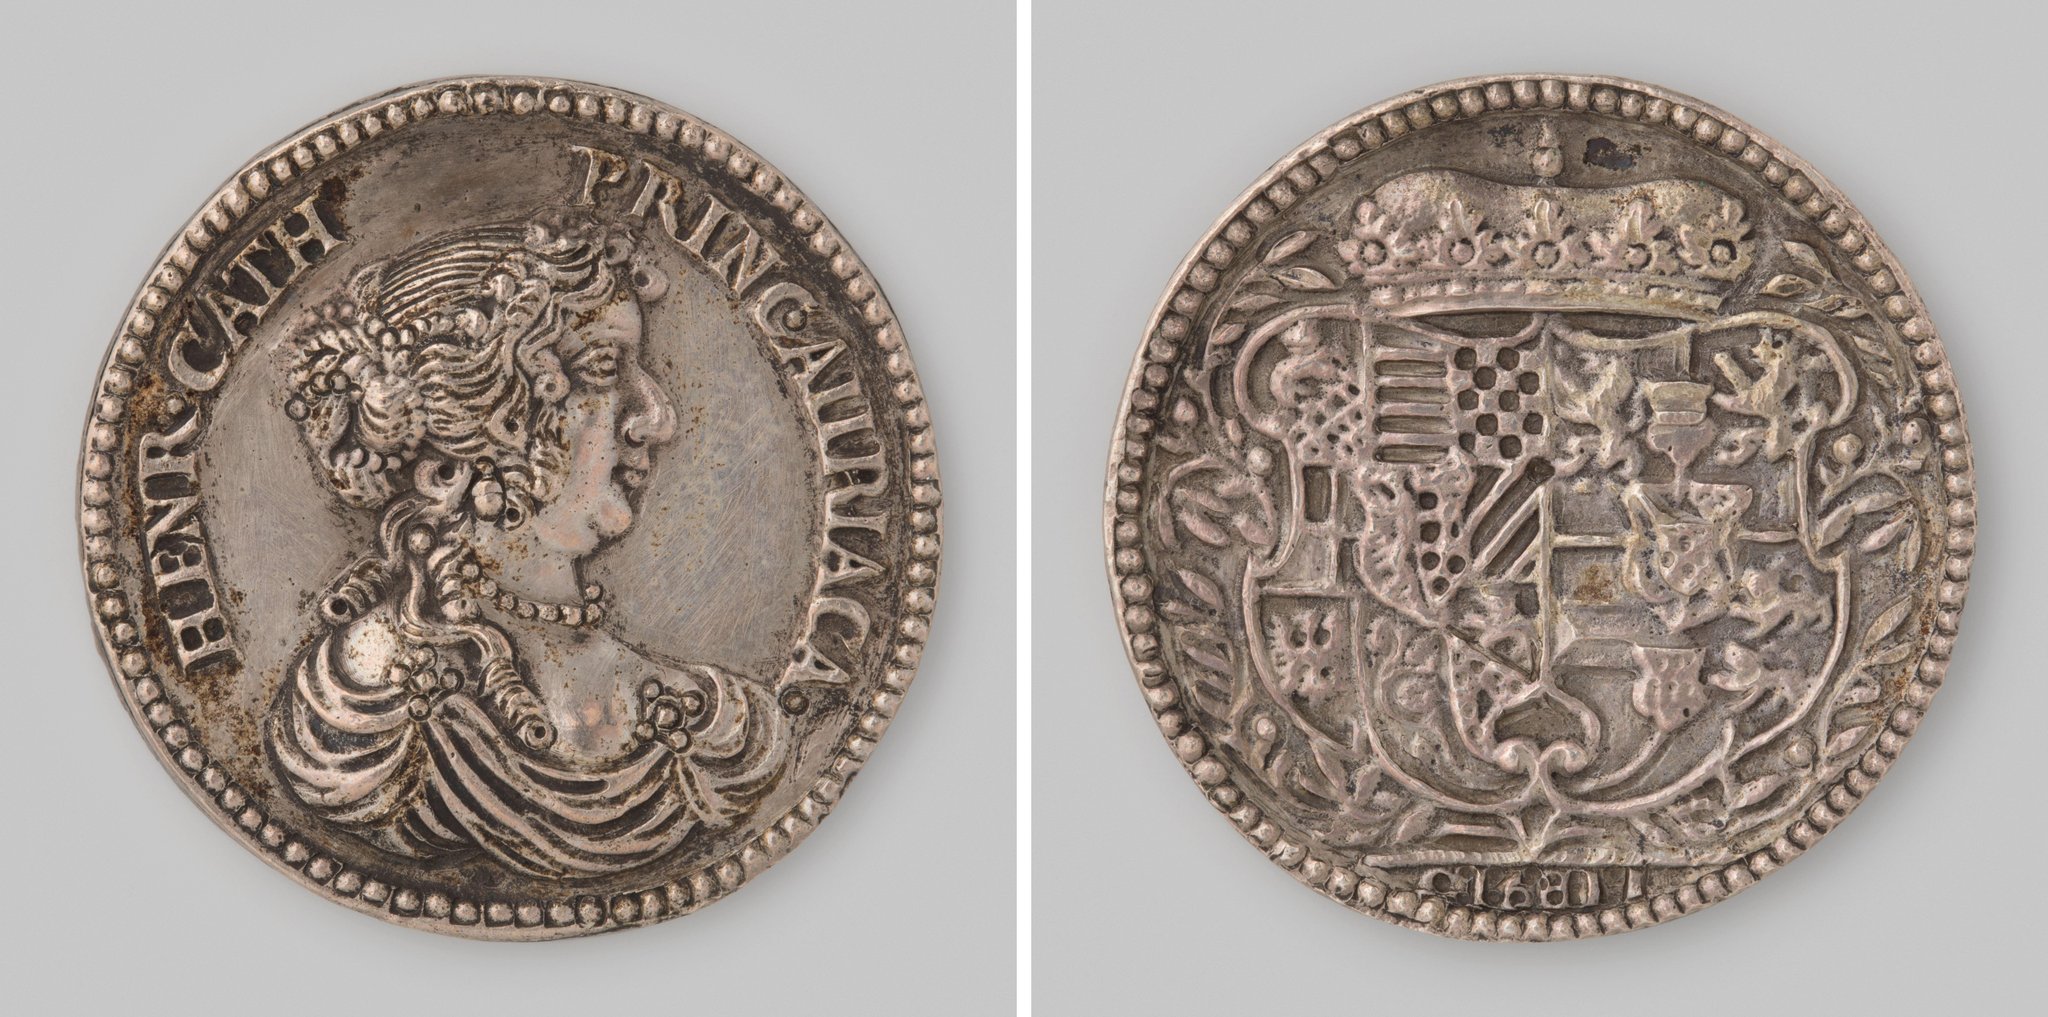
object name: history medal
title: Hendrica Catherina Prinses van Oranje 1681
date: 1681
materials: silver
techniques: casting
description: Zilveren penning, op de voorzijde het borstbeeld van Hendrica naar rechts met omschrift, op de keerzijde een gekroond meerdelig wapenschild tussen lauwertakken, in afsnede 1681.